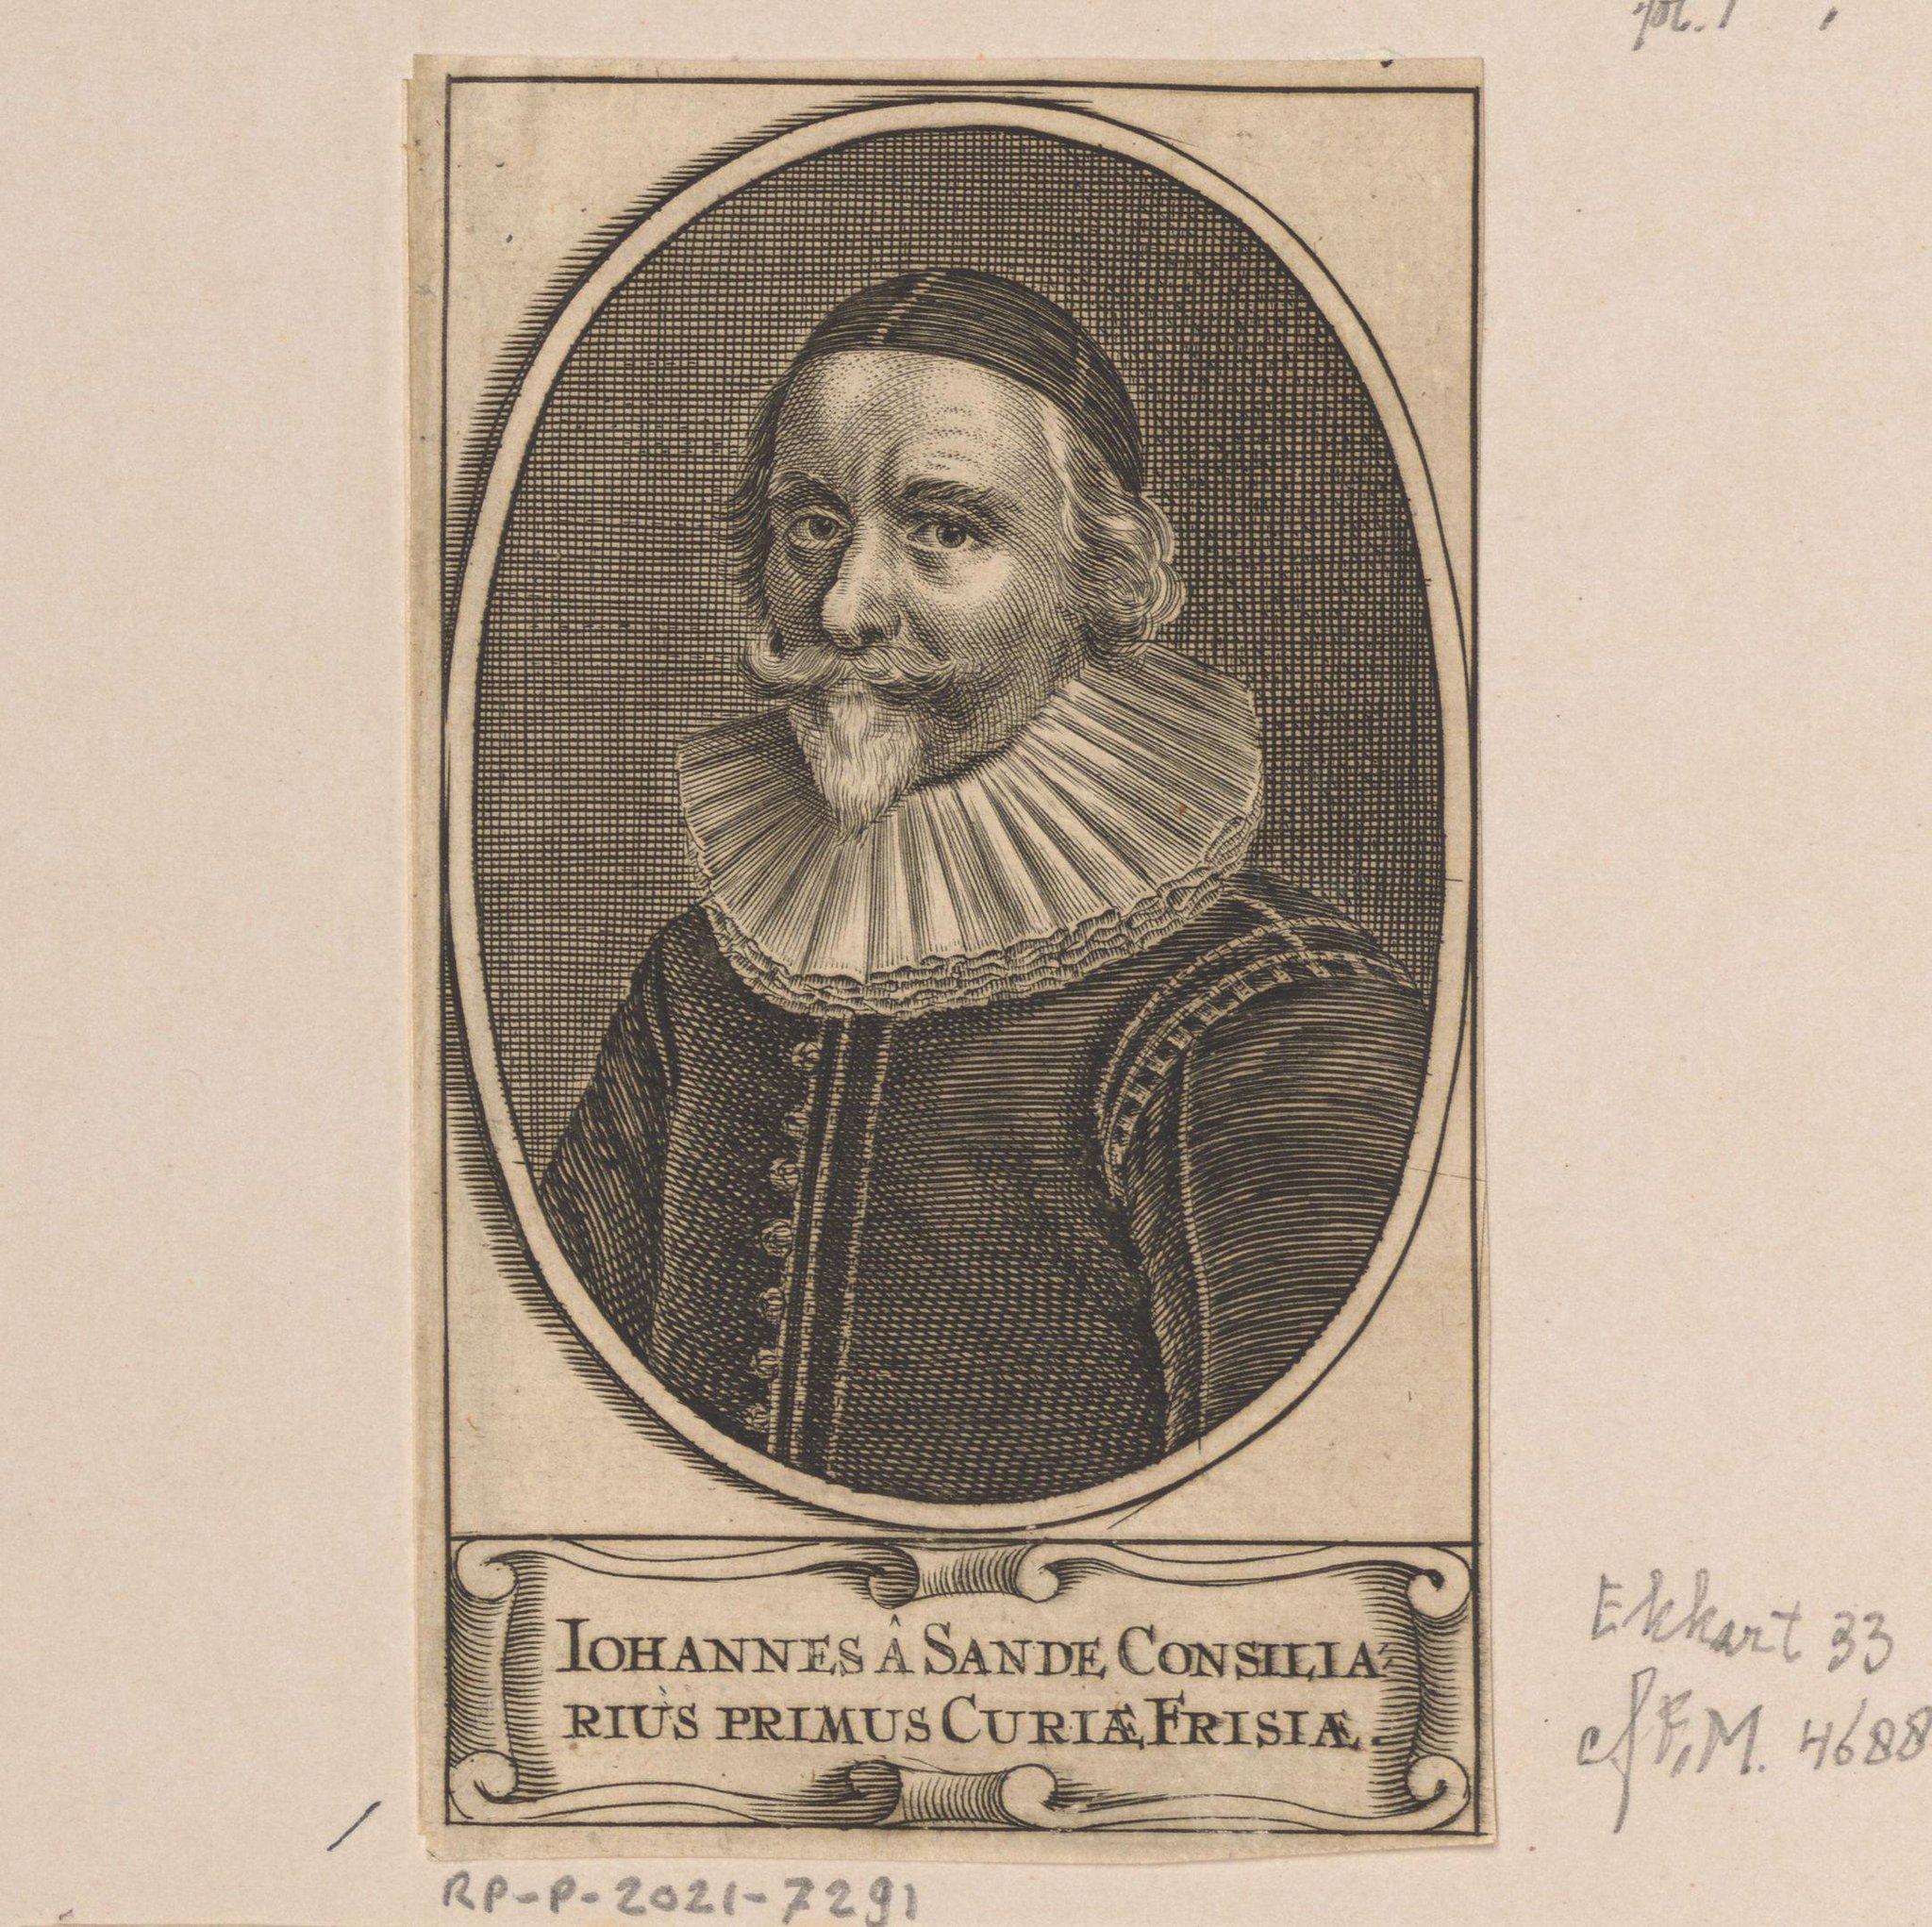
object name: print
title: Portret van Johan van den Sande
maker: Anonymous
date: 1652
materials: paper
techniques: engraving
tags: arnhem, johan van den sande, historical persons, portrait of a writer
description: Prent mogelijk uit: Sande, Johan van den Sande. Belgicarum historiarum epitome (...). Utrecht: Johannes Janssonius van Waesberge I, 1652.